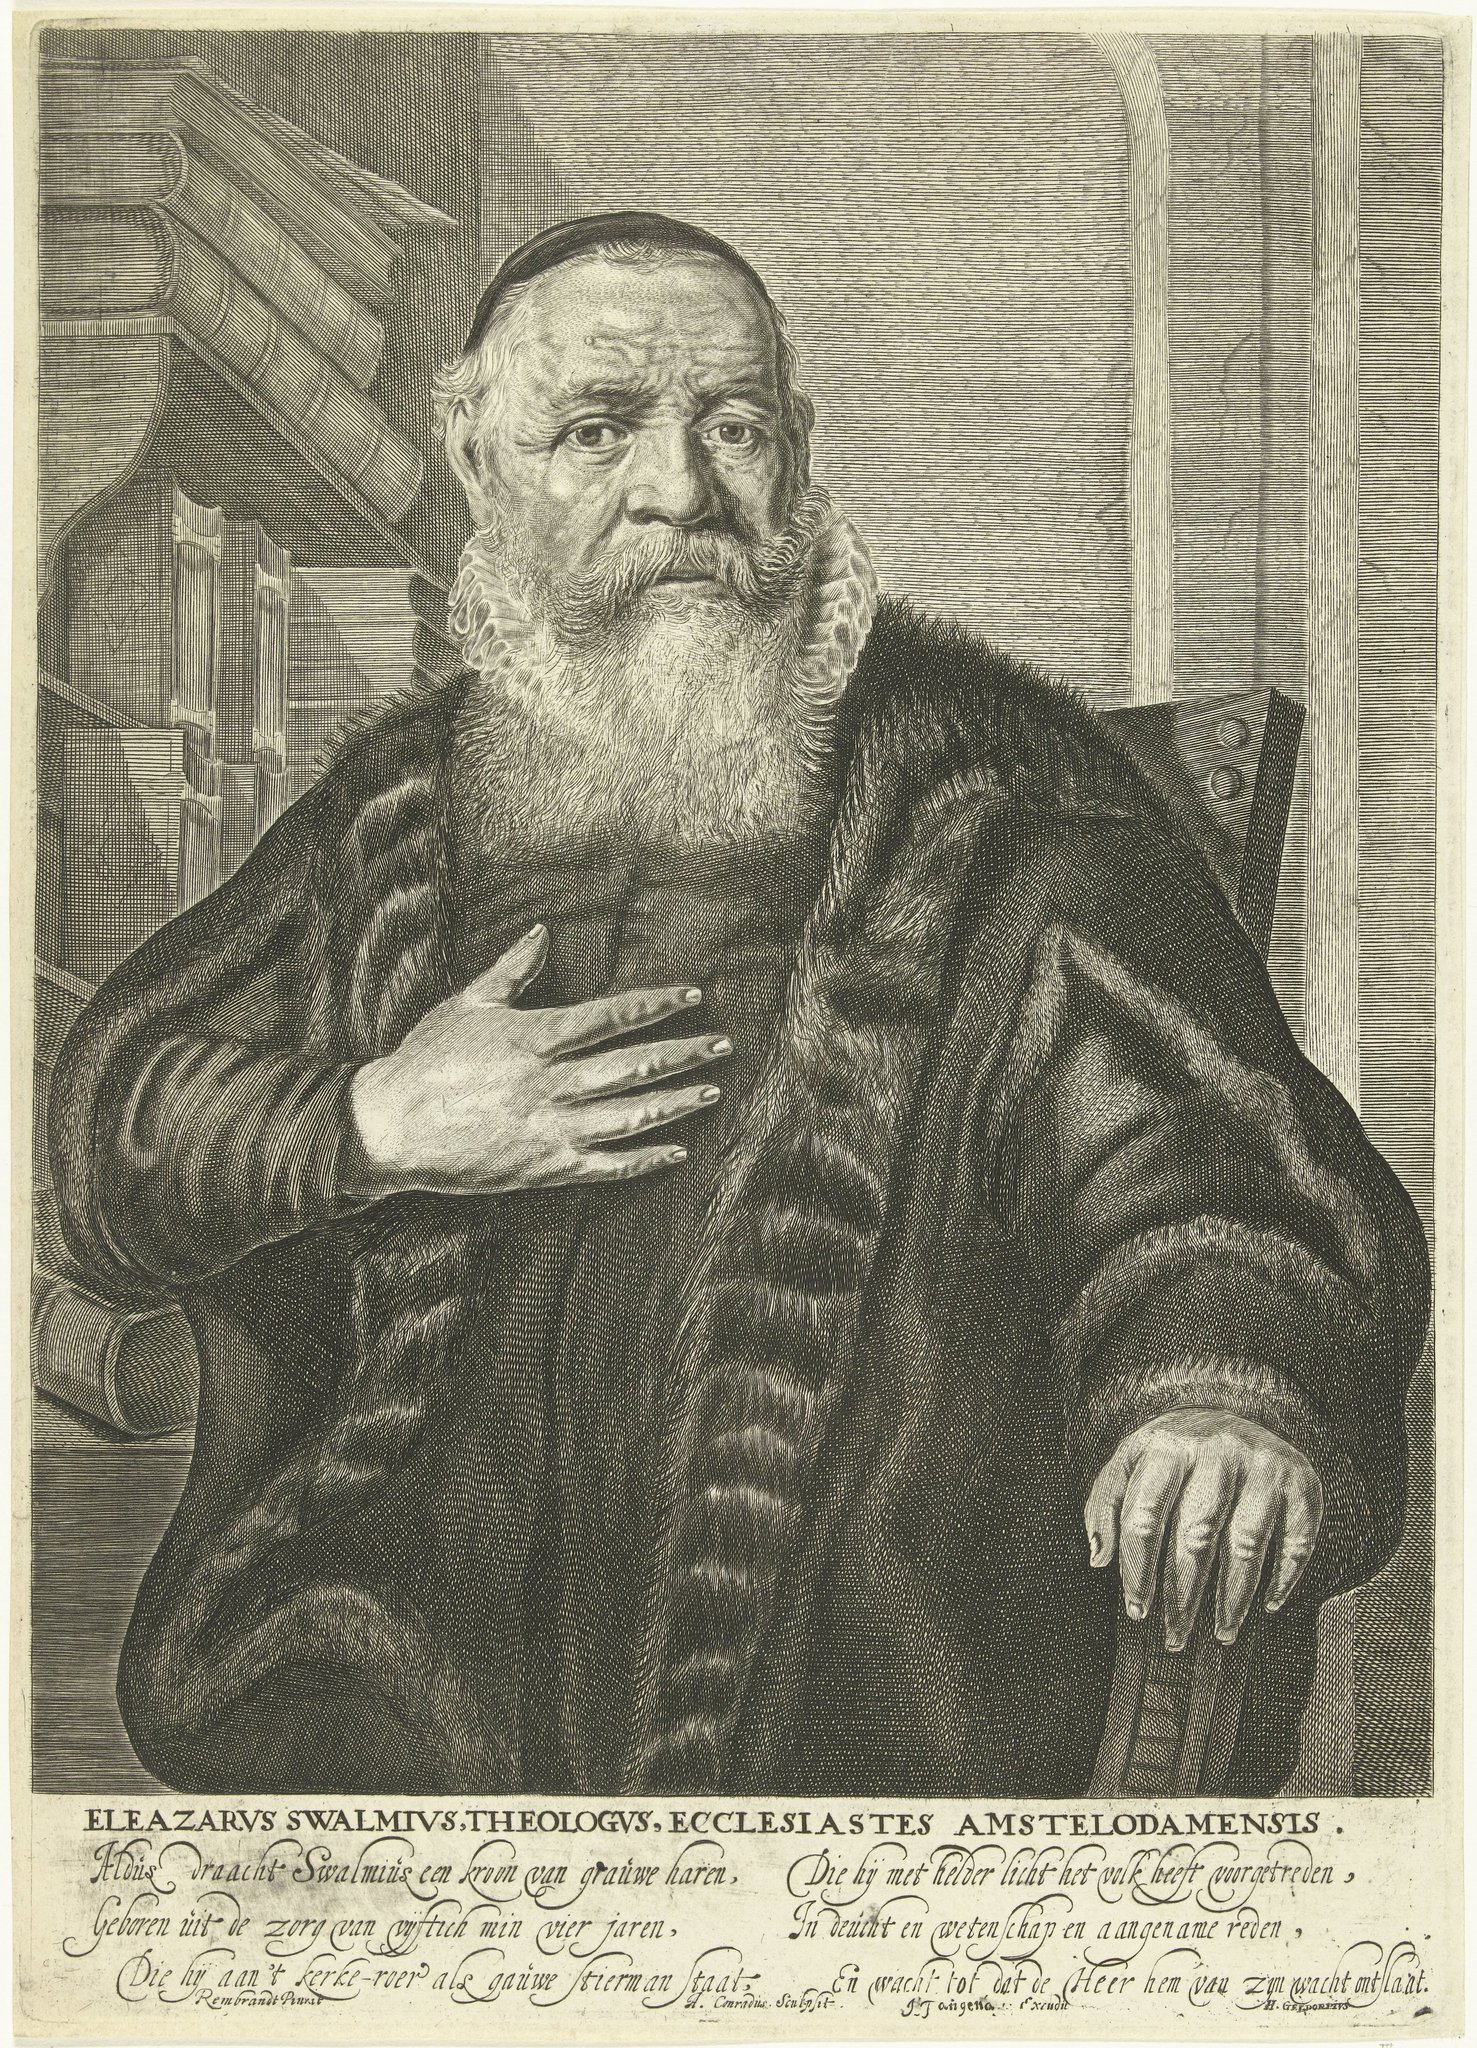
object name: print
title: Portret van Eleazar Swalmius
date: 1650-1660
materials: paper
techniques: engraving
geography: amsterdam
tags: amsterdam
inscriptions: collector's mark: Lugt 2228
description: Portret van de predikant Eleazar Swalmius zittend in zijn studeervertrek. Links tegen de muur is een boekenkast geplaatst. Swalmius houdt de rechte hand op zijn borst. Onder het portret een Nederlands lofdicht door H. Geldorpius.